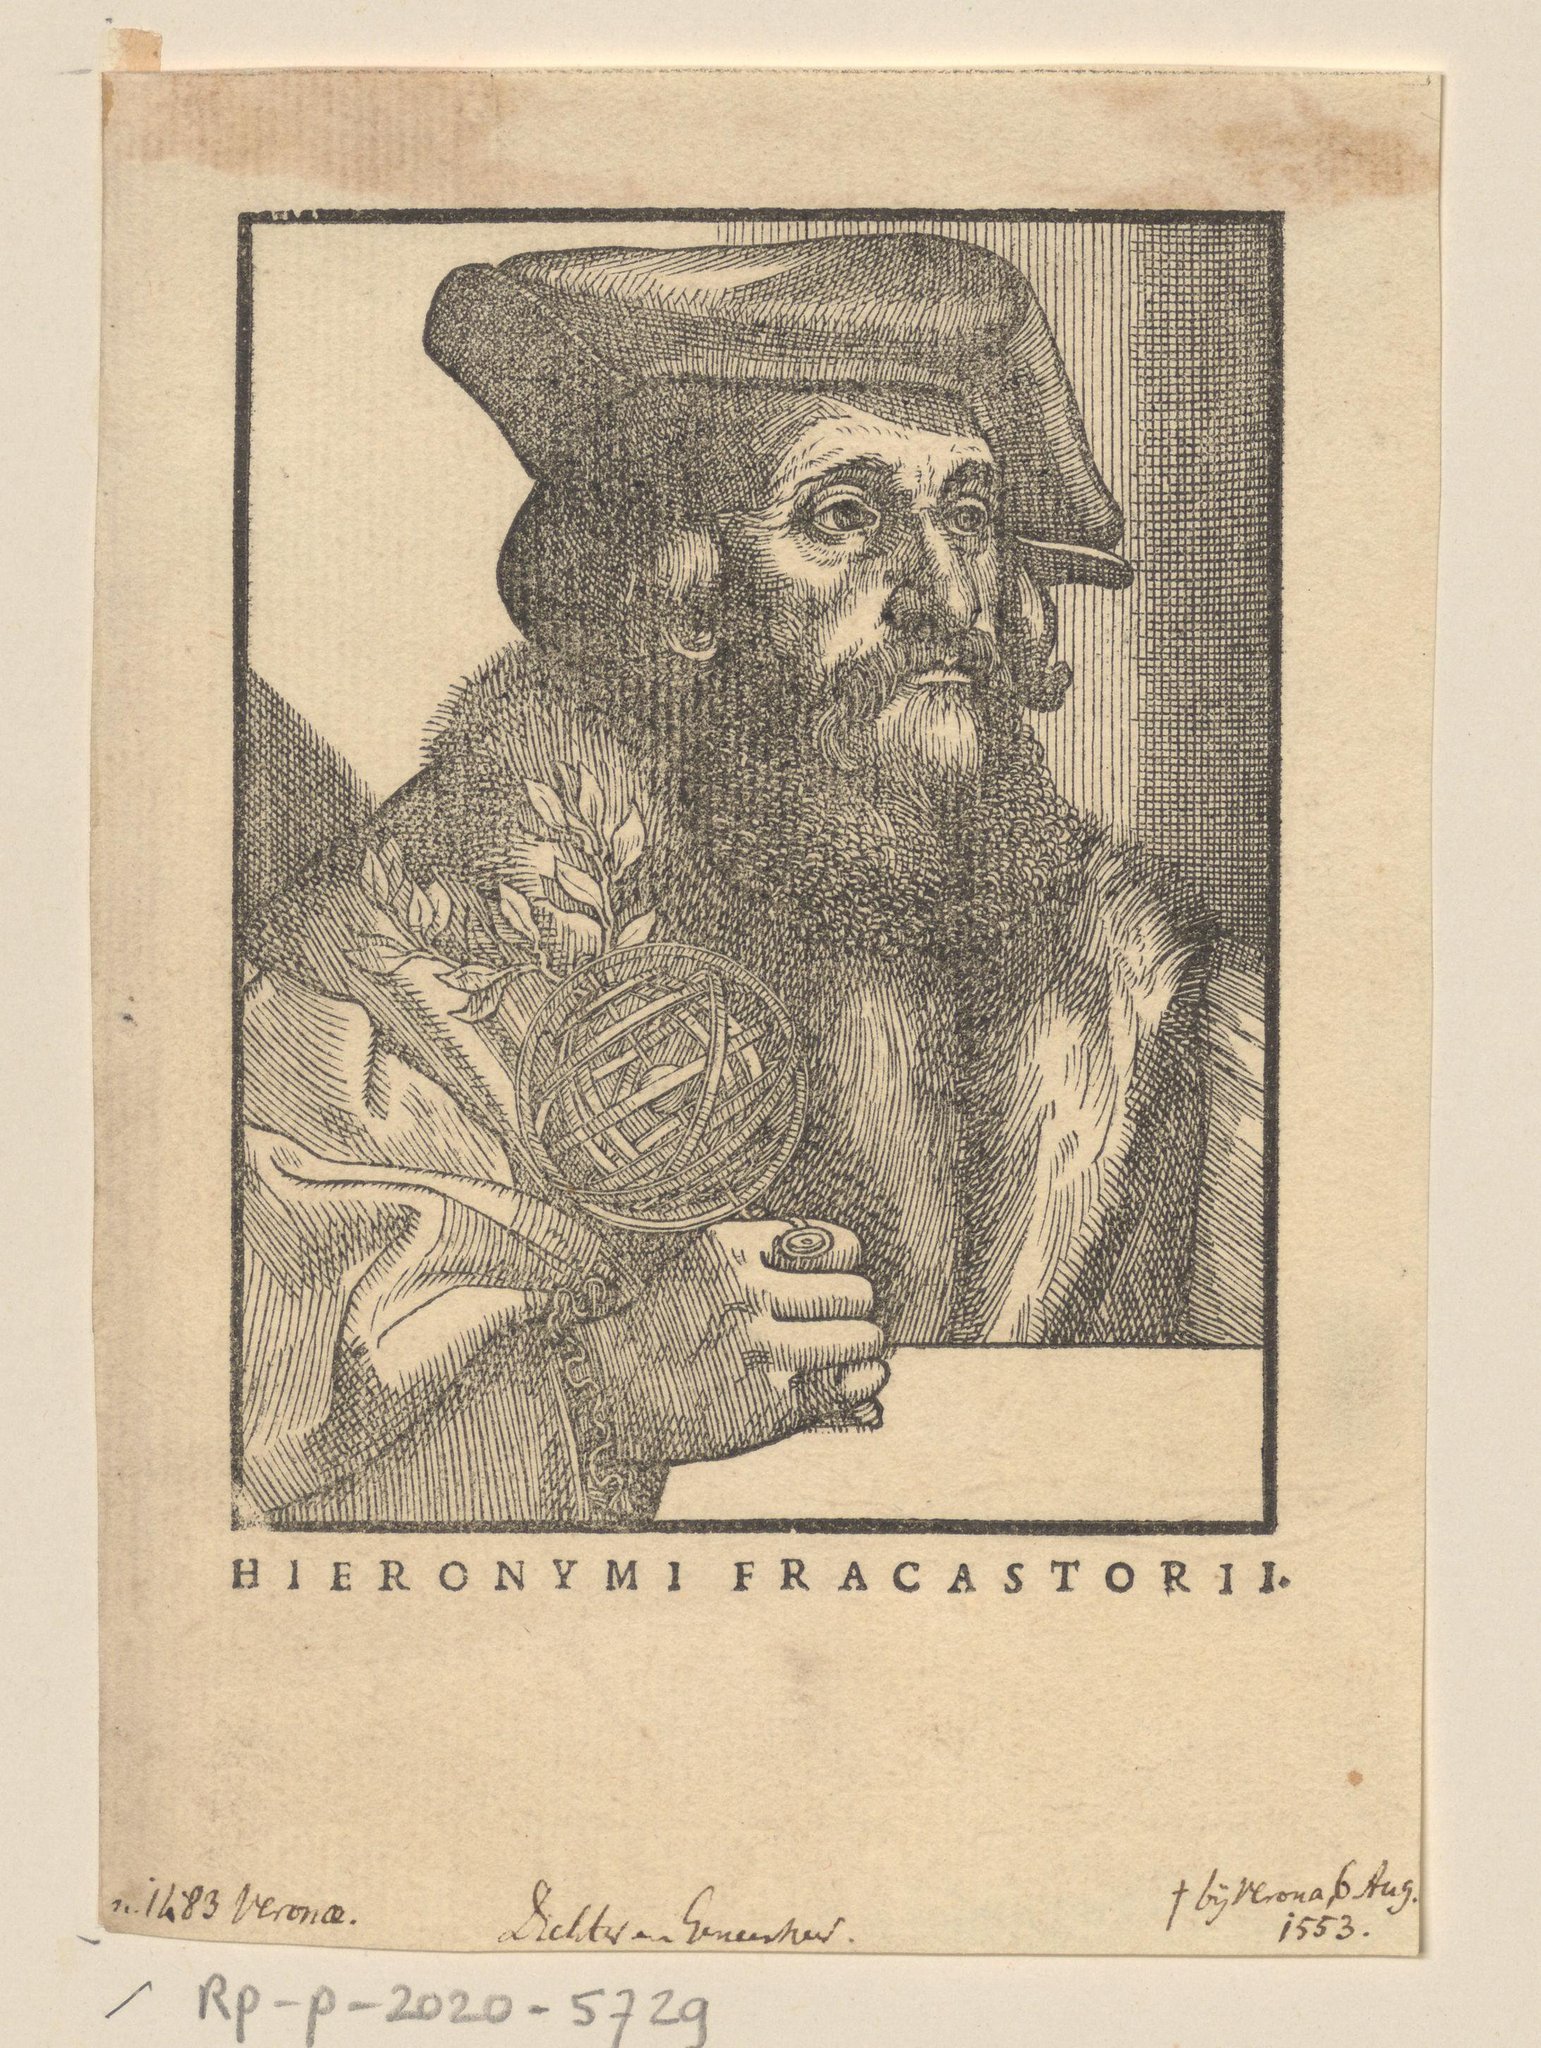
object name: print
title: Portret van Girolamo Fracastoro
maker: Anonymous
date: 1538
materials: paper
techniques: woodcut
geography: italy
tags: historical persons, portrait of a writer, physician, doctor (+ portrait of scholar, scientist)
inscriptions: inscription: ‘n. 1483 Verona/ Dichter en Geneesheer/ +bij Verona 6 Aug/ 1553’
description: Prent met tekst in boekdruk op verso gebruikt in: Fracastoro, Girolamo. Homocentrica (...). Venetië: s.n., 1538.